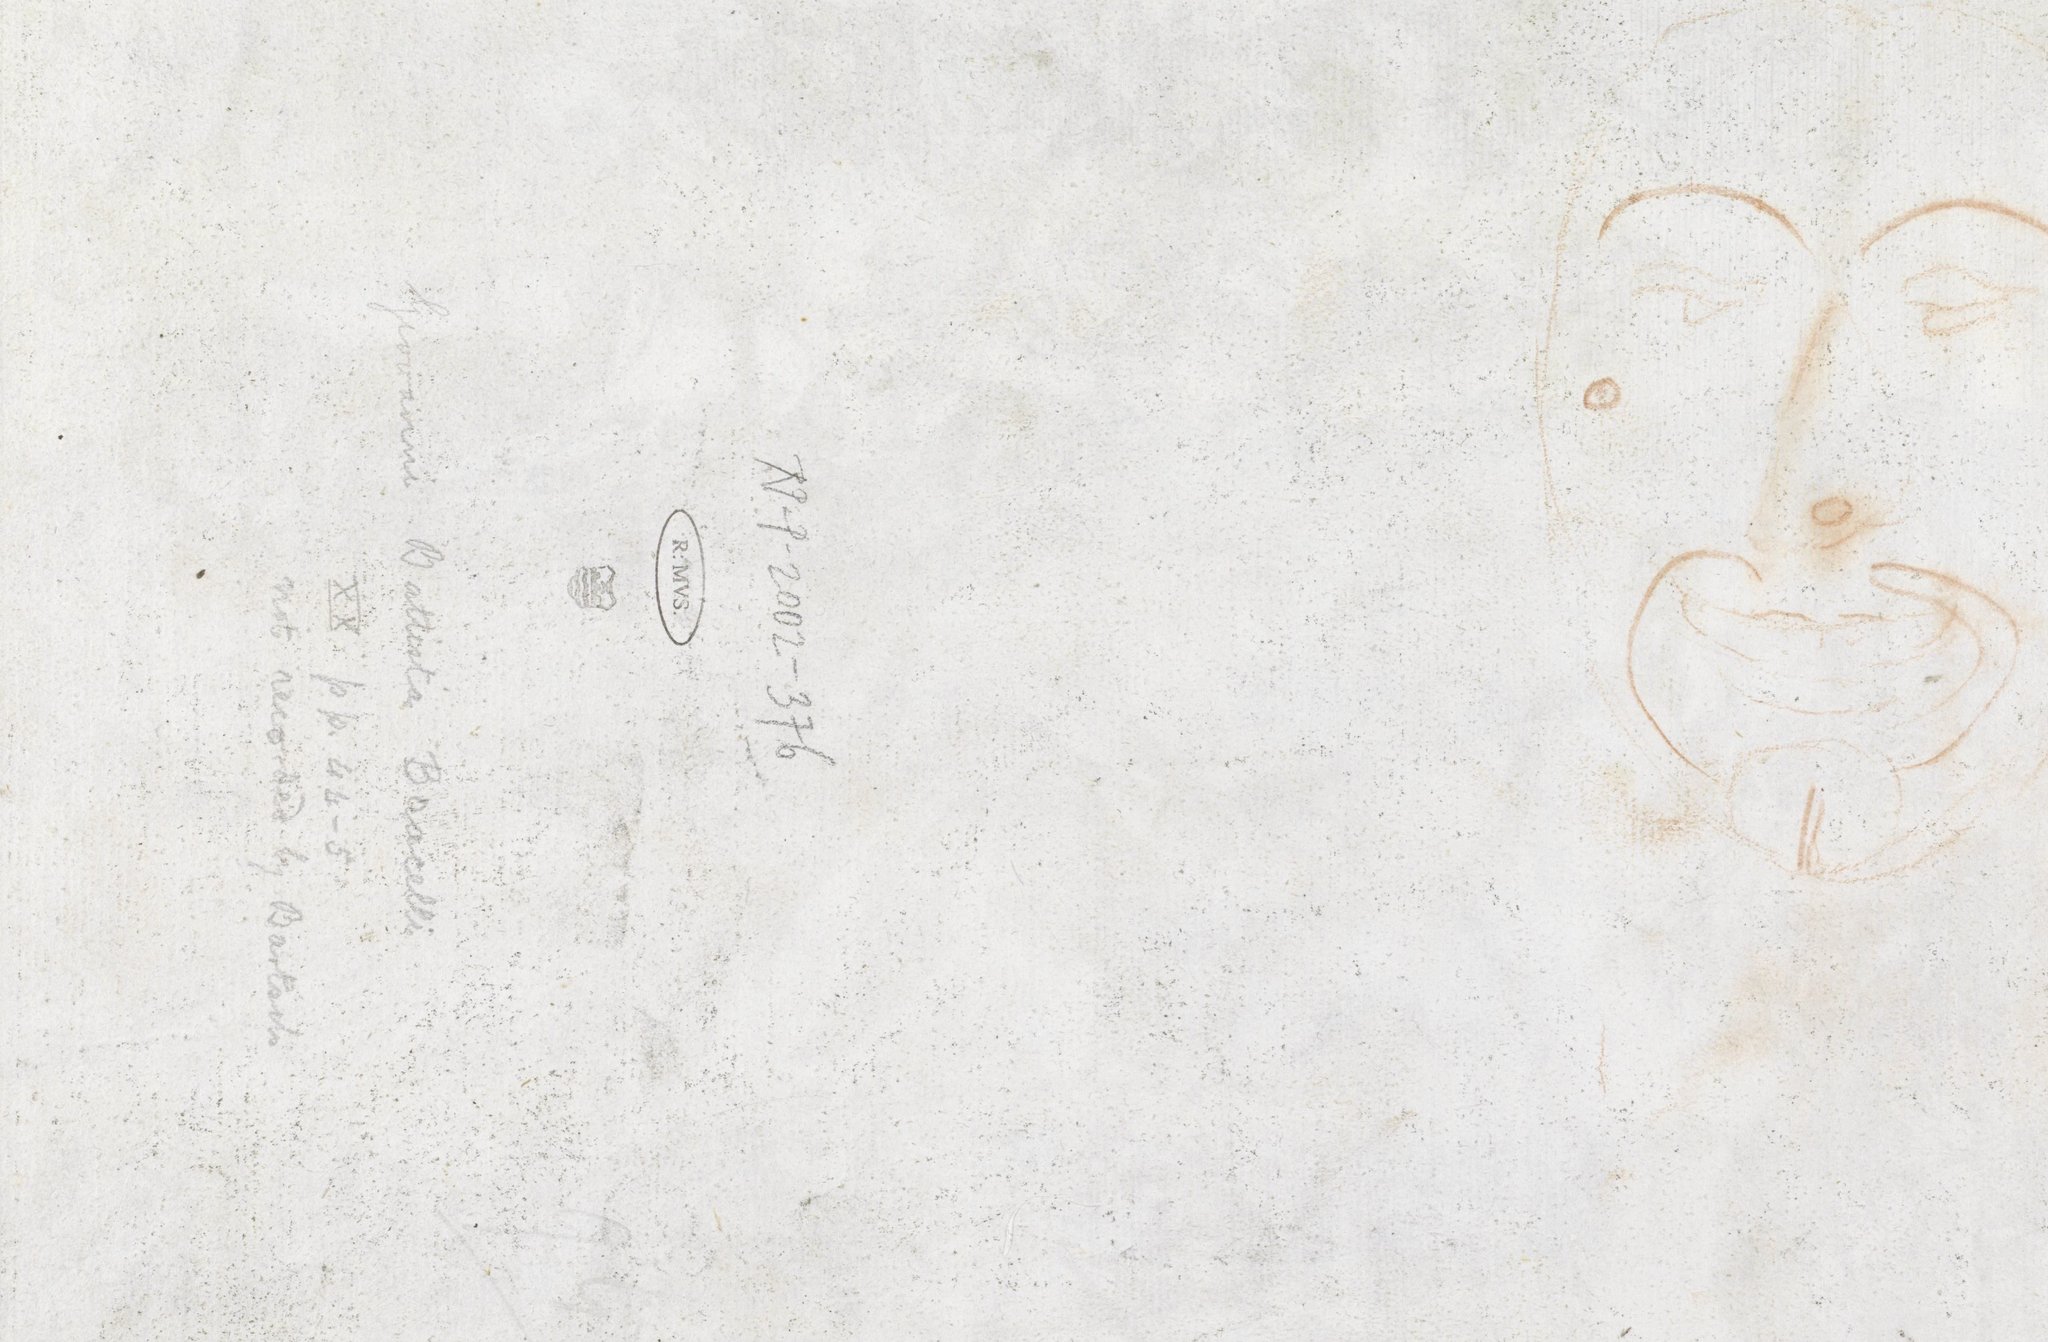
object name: print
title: Gezicht met wratten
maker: Anonymous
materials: chalk, paper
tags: face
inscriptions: collector's mark: Lugt 2228, collector's mark: Lugt 2760